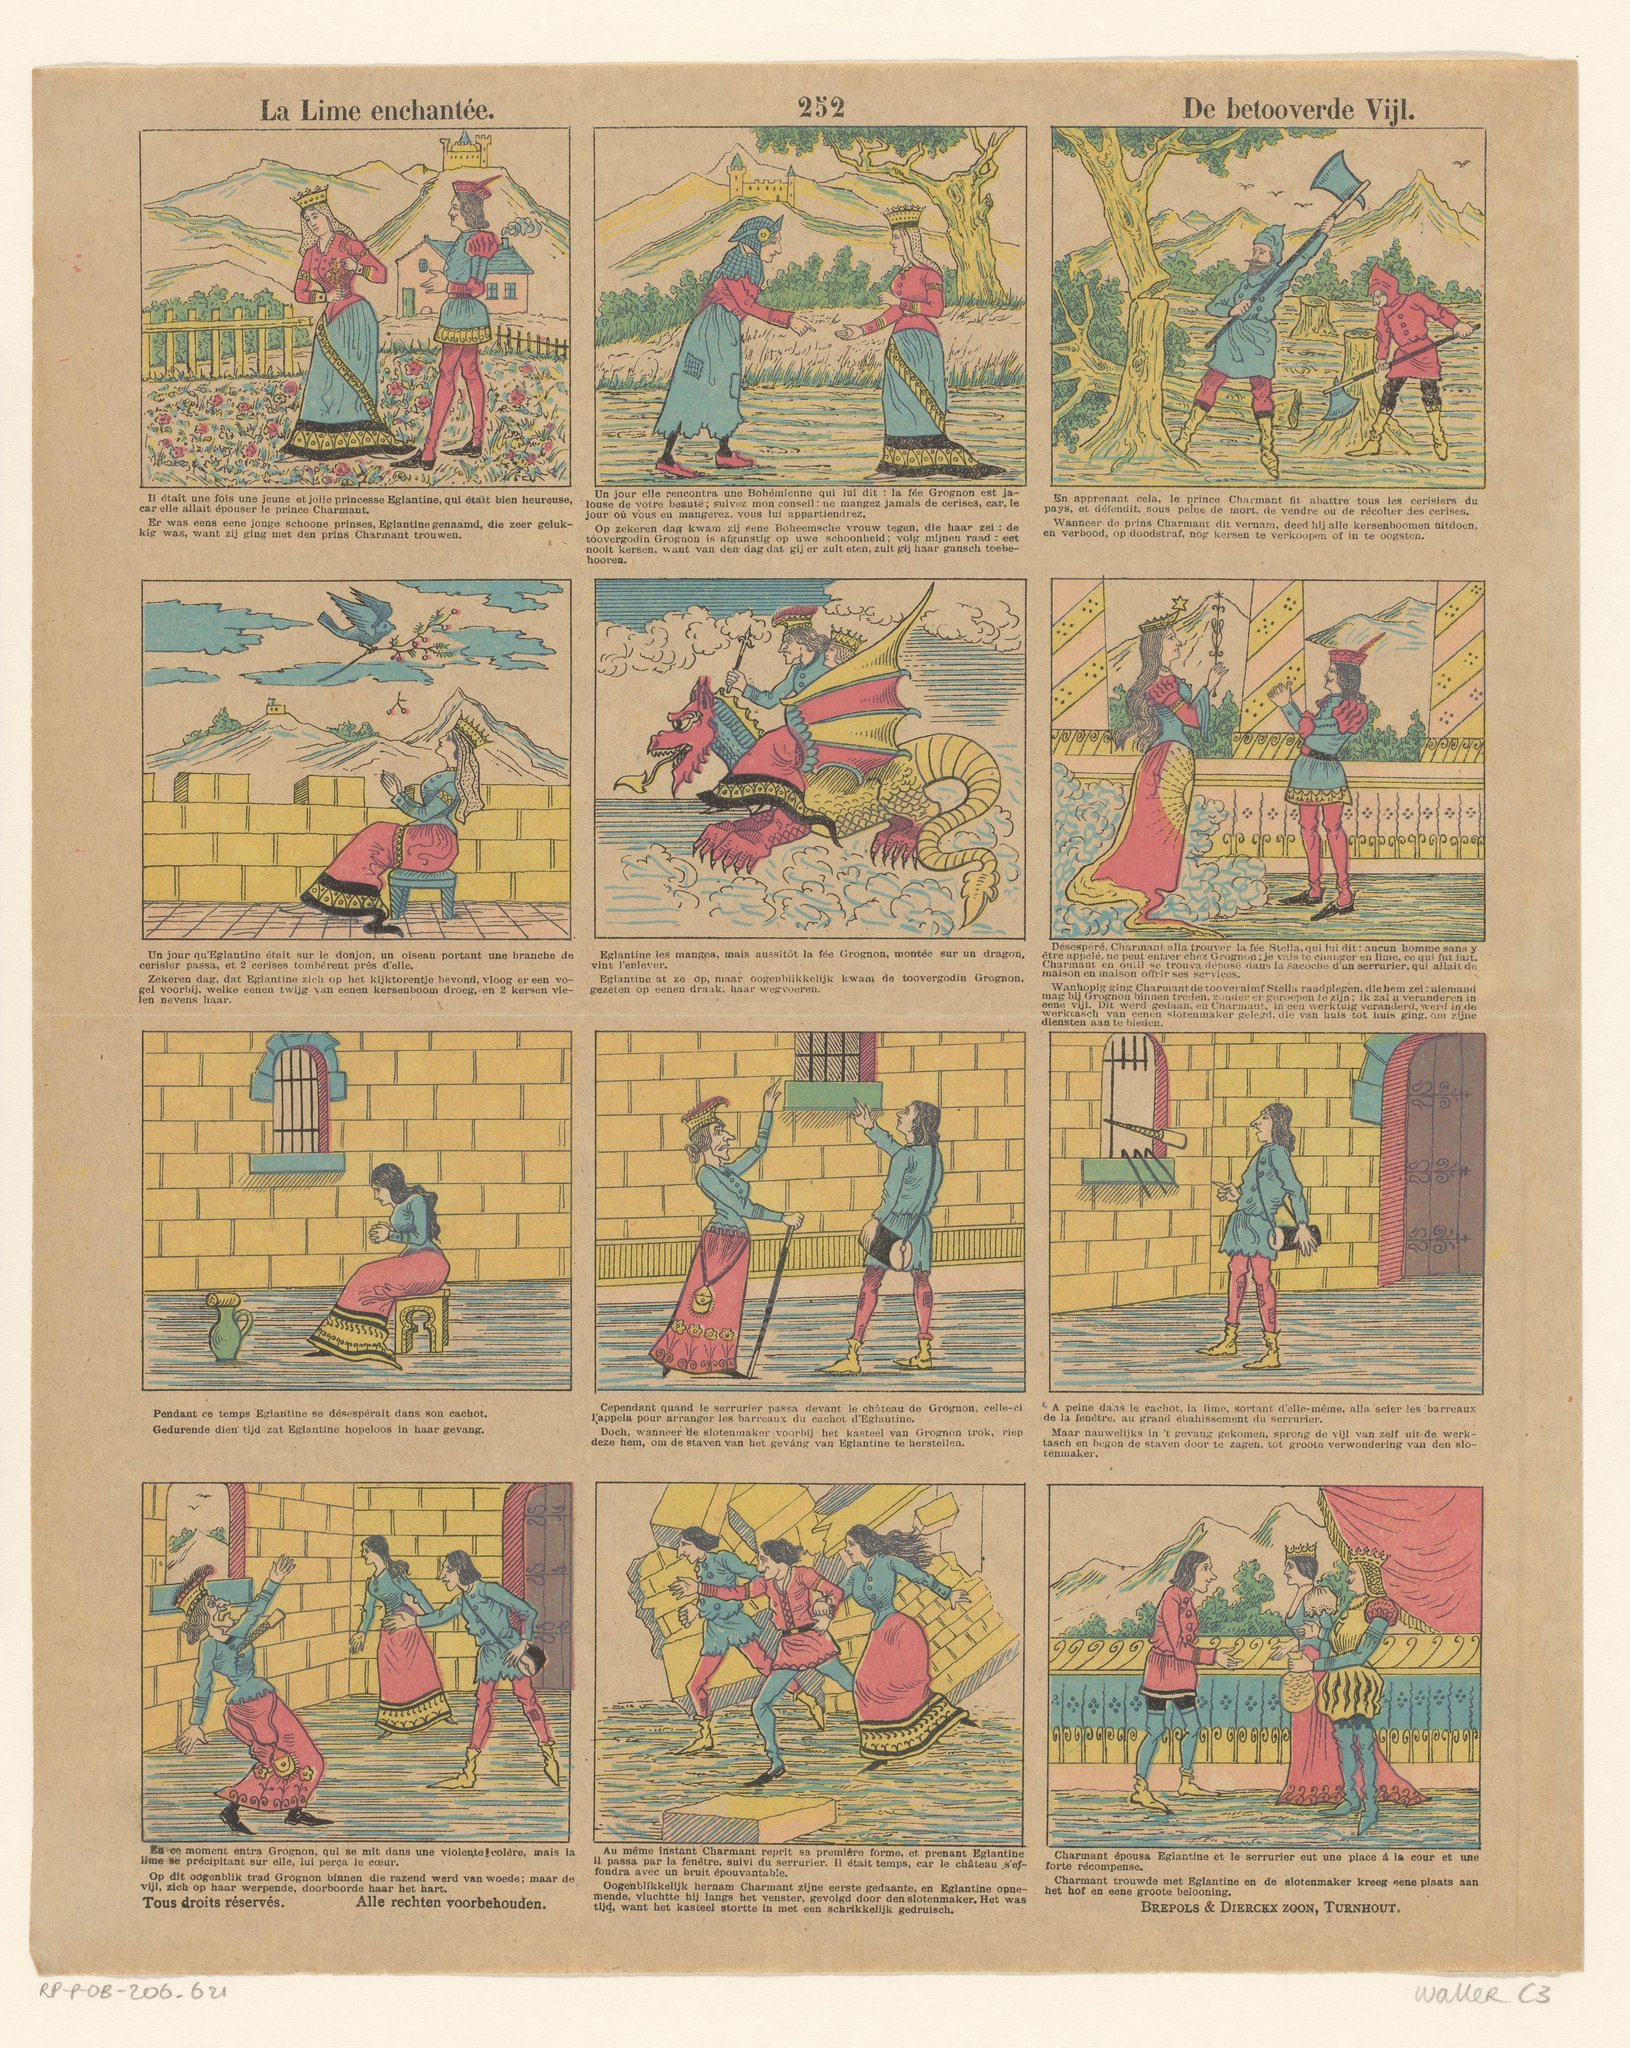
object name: popular print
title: La lime enchantée / De betooverde vijl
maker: Anonymous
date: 1833-1911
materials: paper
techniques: lithograph, letterpress printing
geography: turnhout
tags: prince, princess, tales and fairy tales, dragon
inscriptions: octrooivermelding, gedrukt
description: Blad met 12 voorstellingen uit het verhaal van de betoverde vijl. Onder elke afbeelding een onderschrift in het Nederlands en in het Frans. Genummerd midden boven: 252.